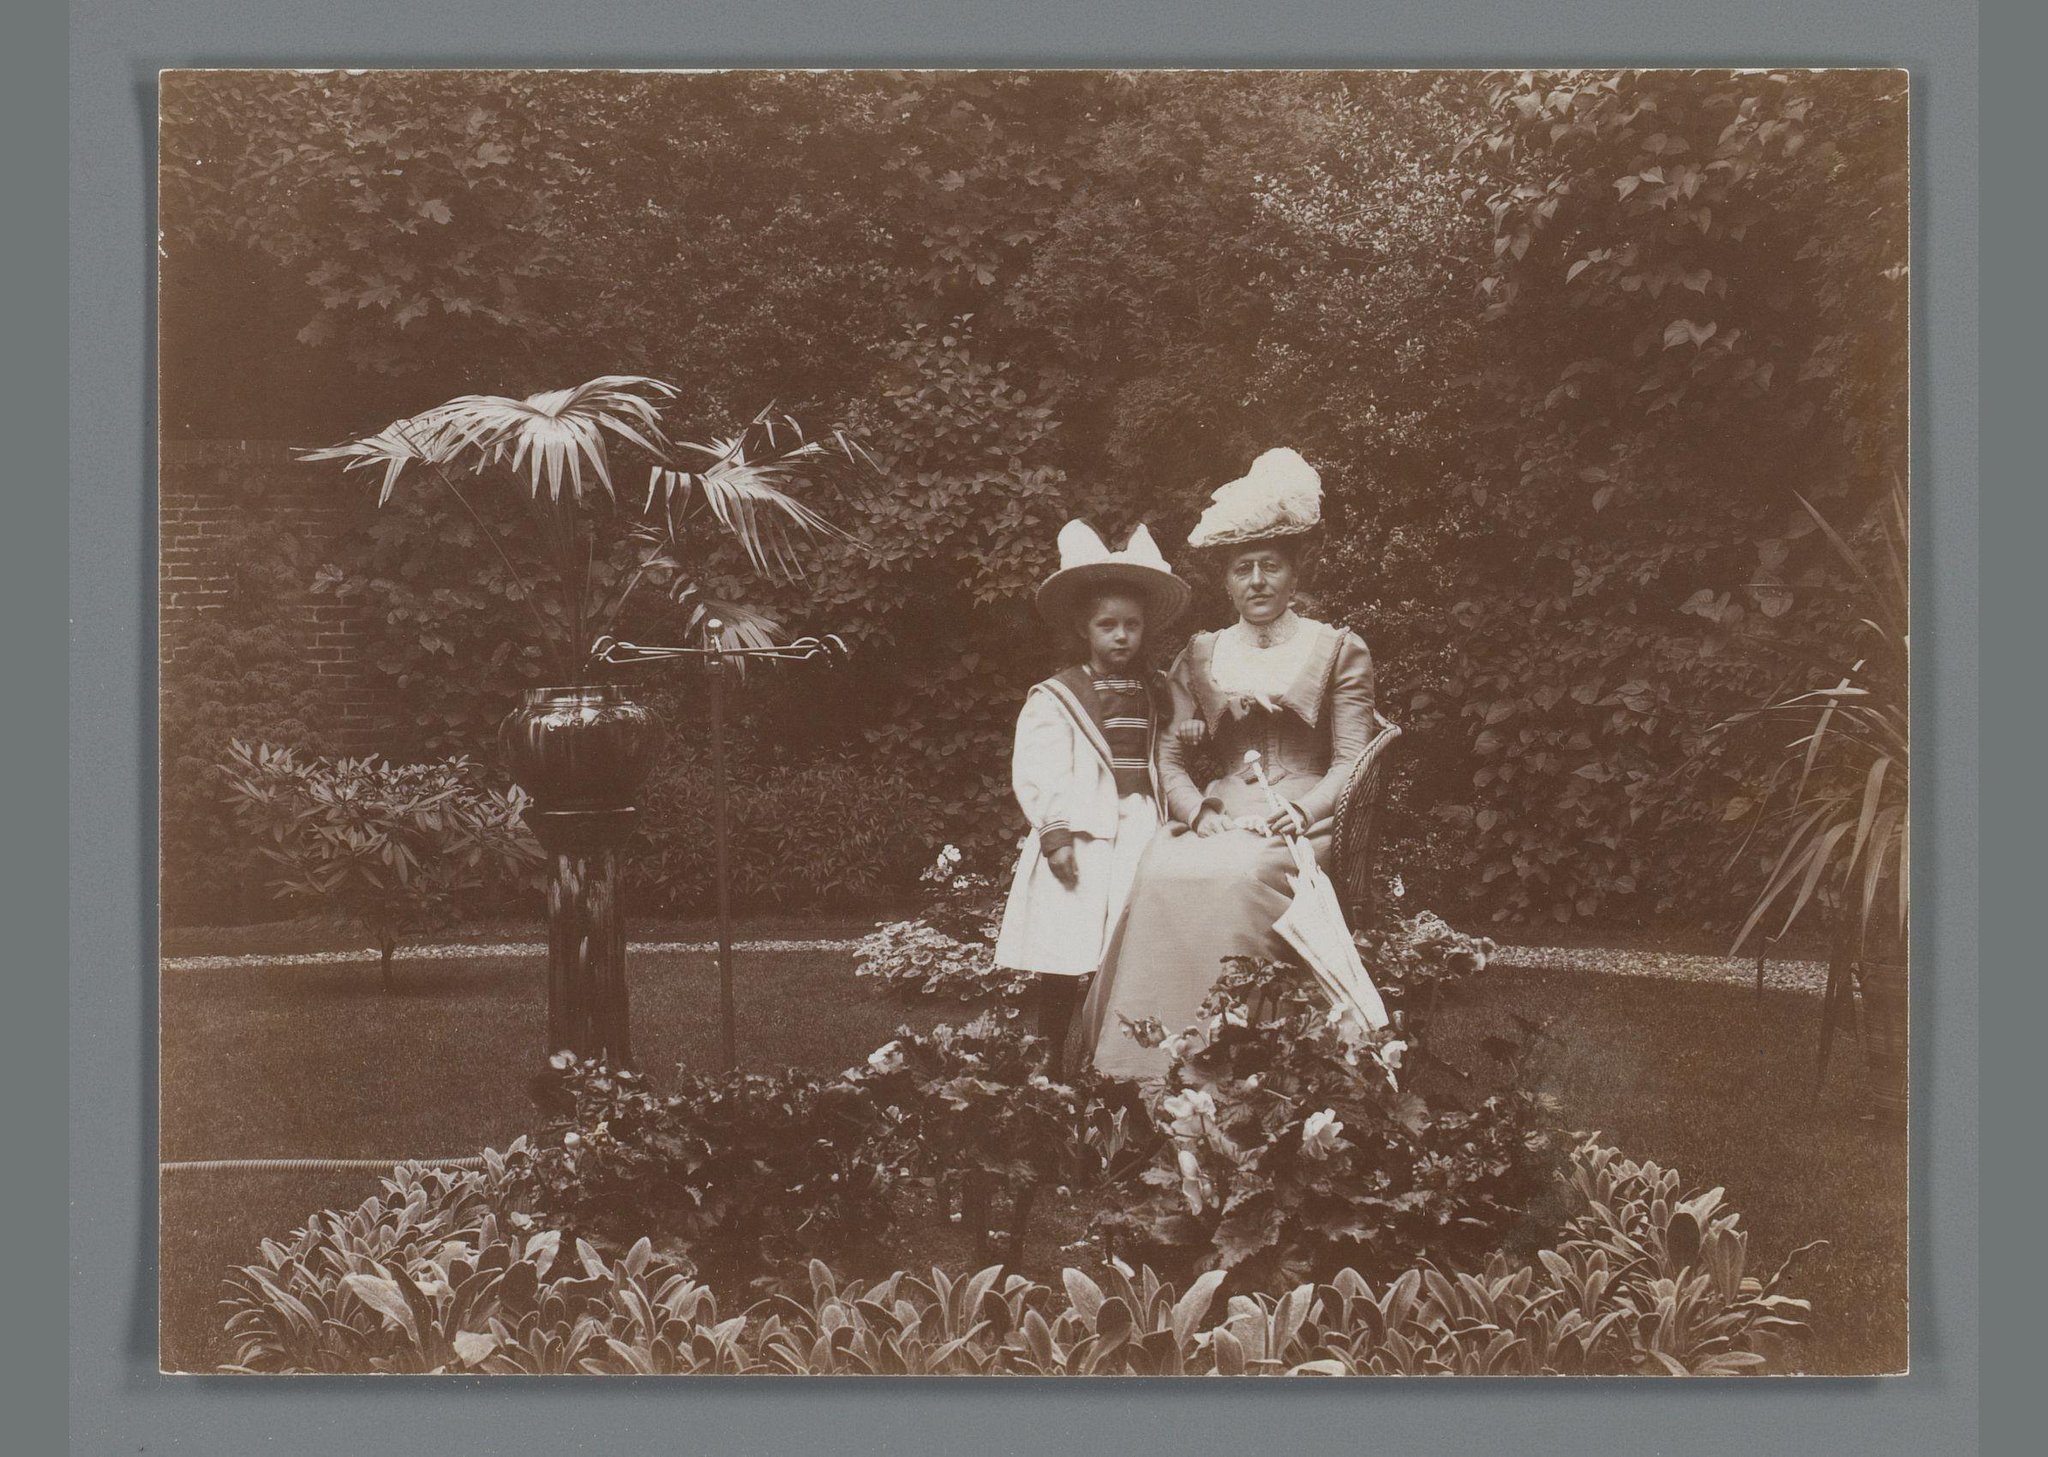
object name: photograph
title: Portret van Johanna (Hans) de Jong en Hendrina (Dina) Johanna de Jong-Ploeg in de tuin van Piet de Jong in Arnhem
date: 1902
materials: paper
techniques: gelatin silver print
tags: leiden, johanna petronella lambertina stokhuyzen-de jong (hans), arnhem, hendrina johanna de jong-ploeg (dina), garden, historical persons